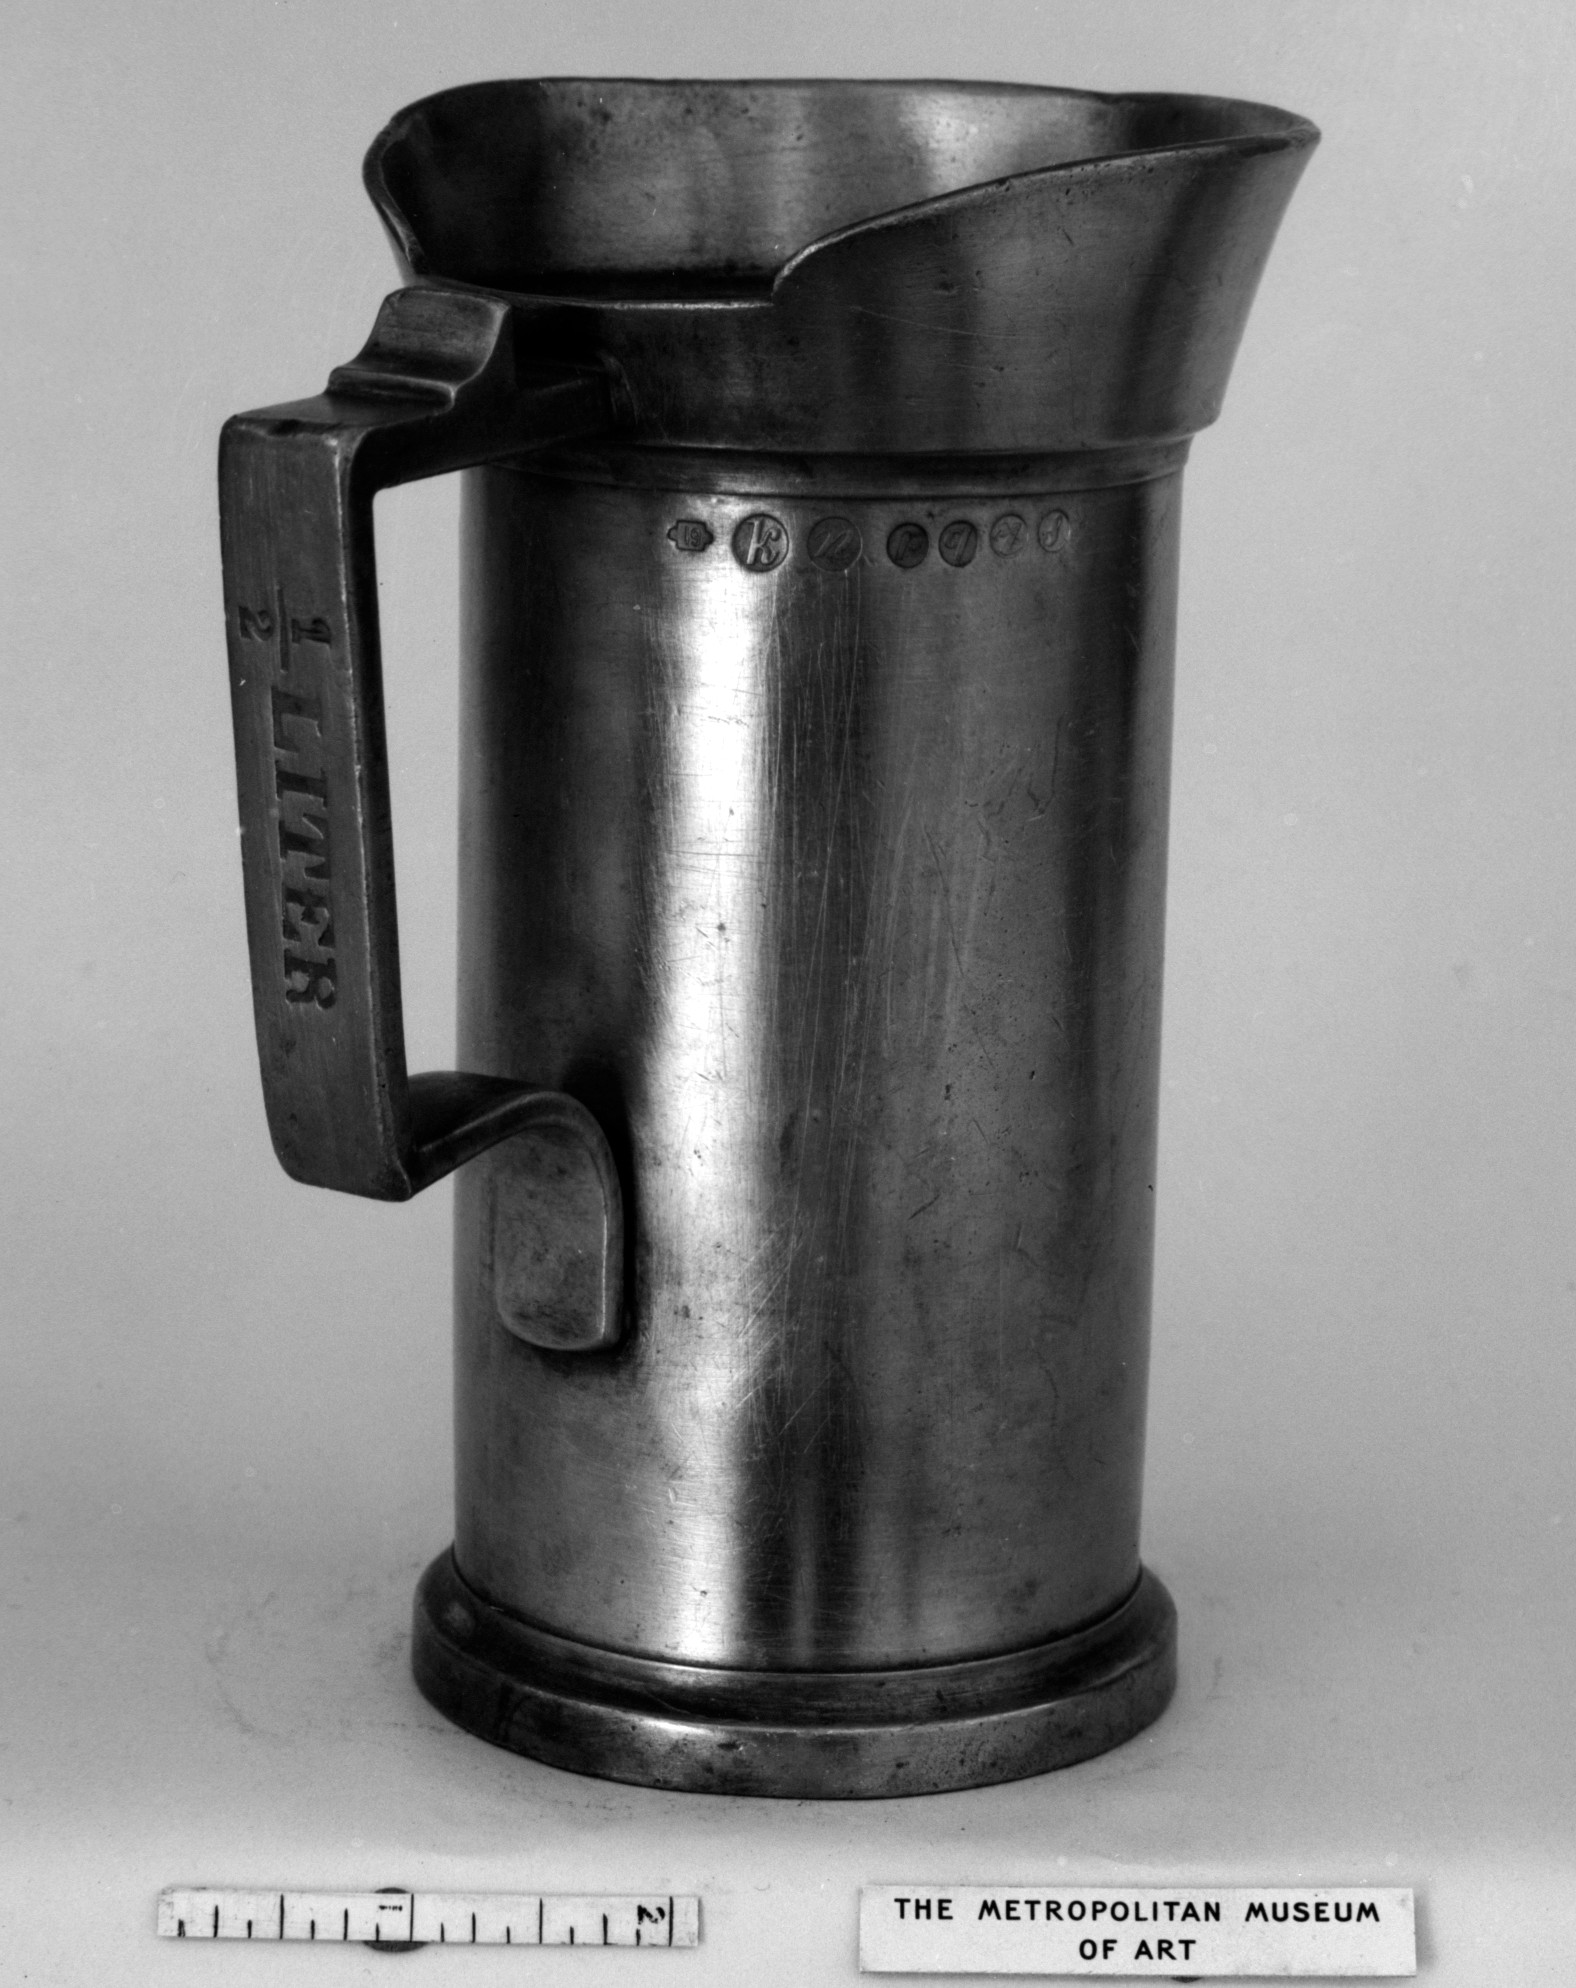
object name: measure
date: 1801-1833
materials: pewter